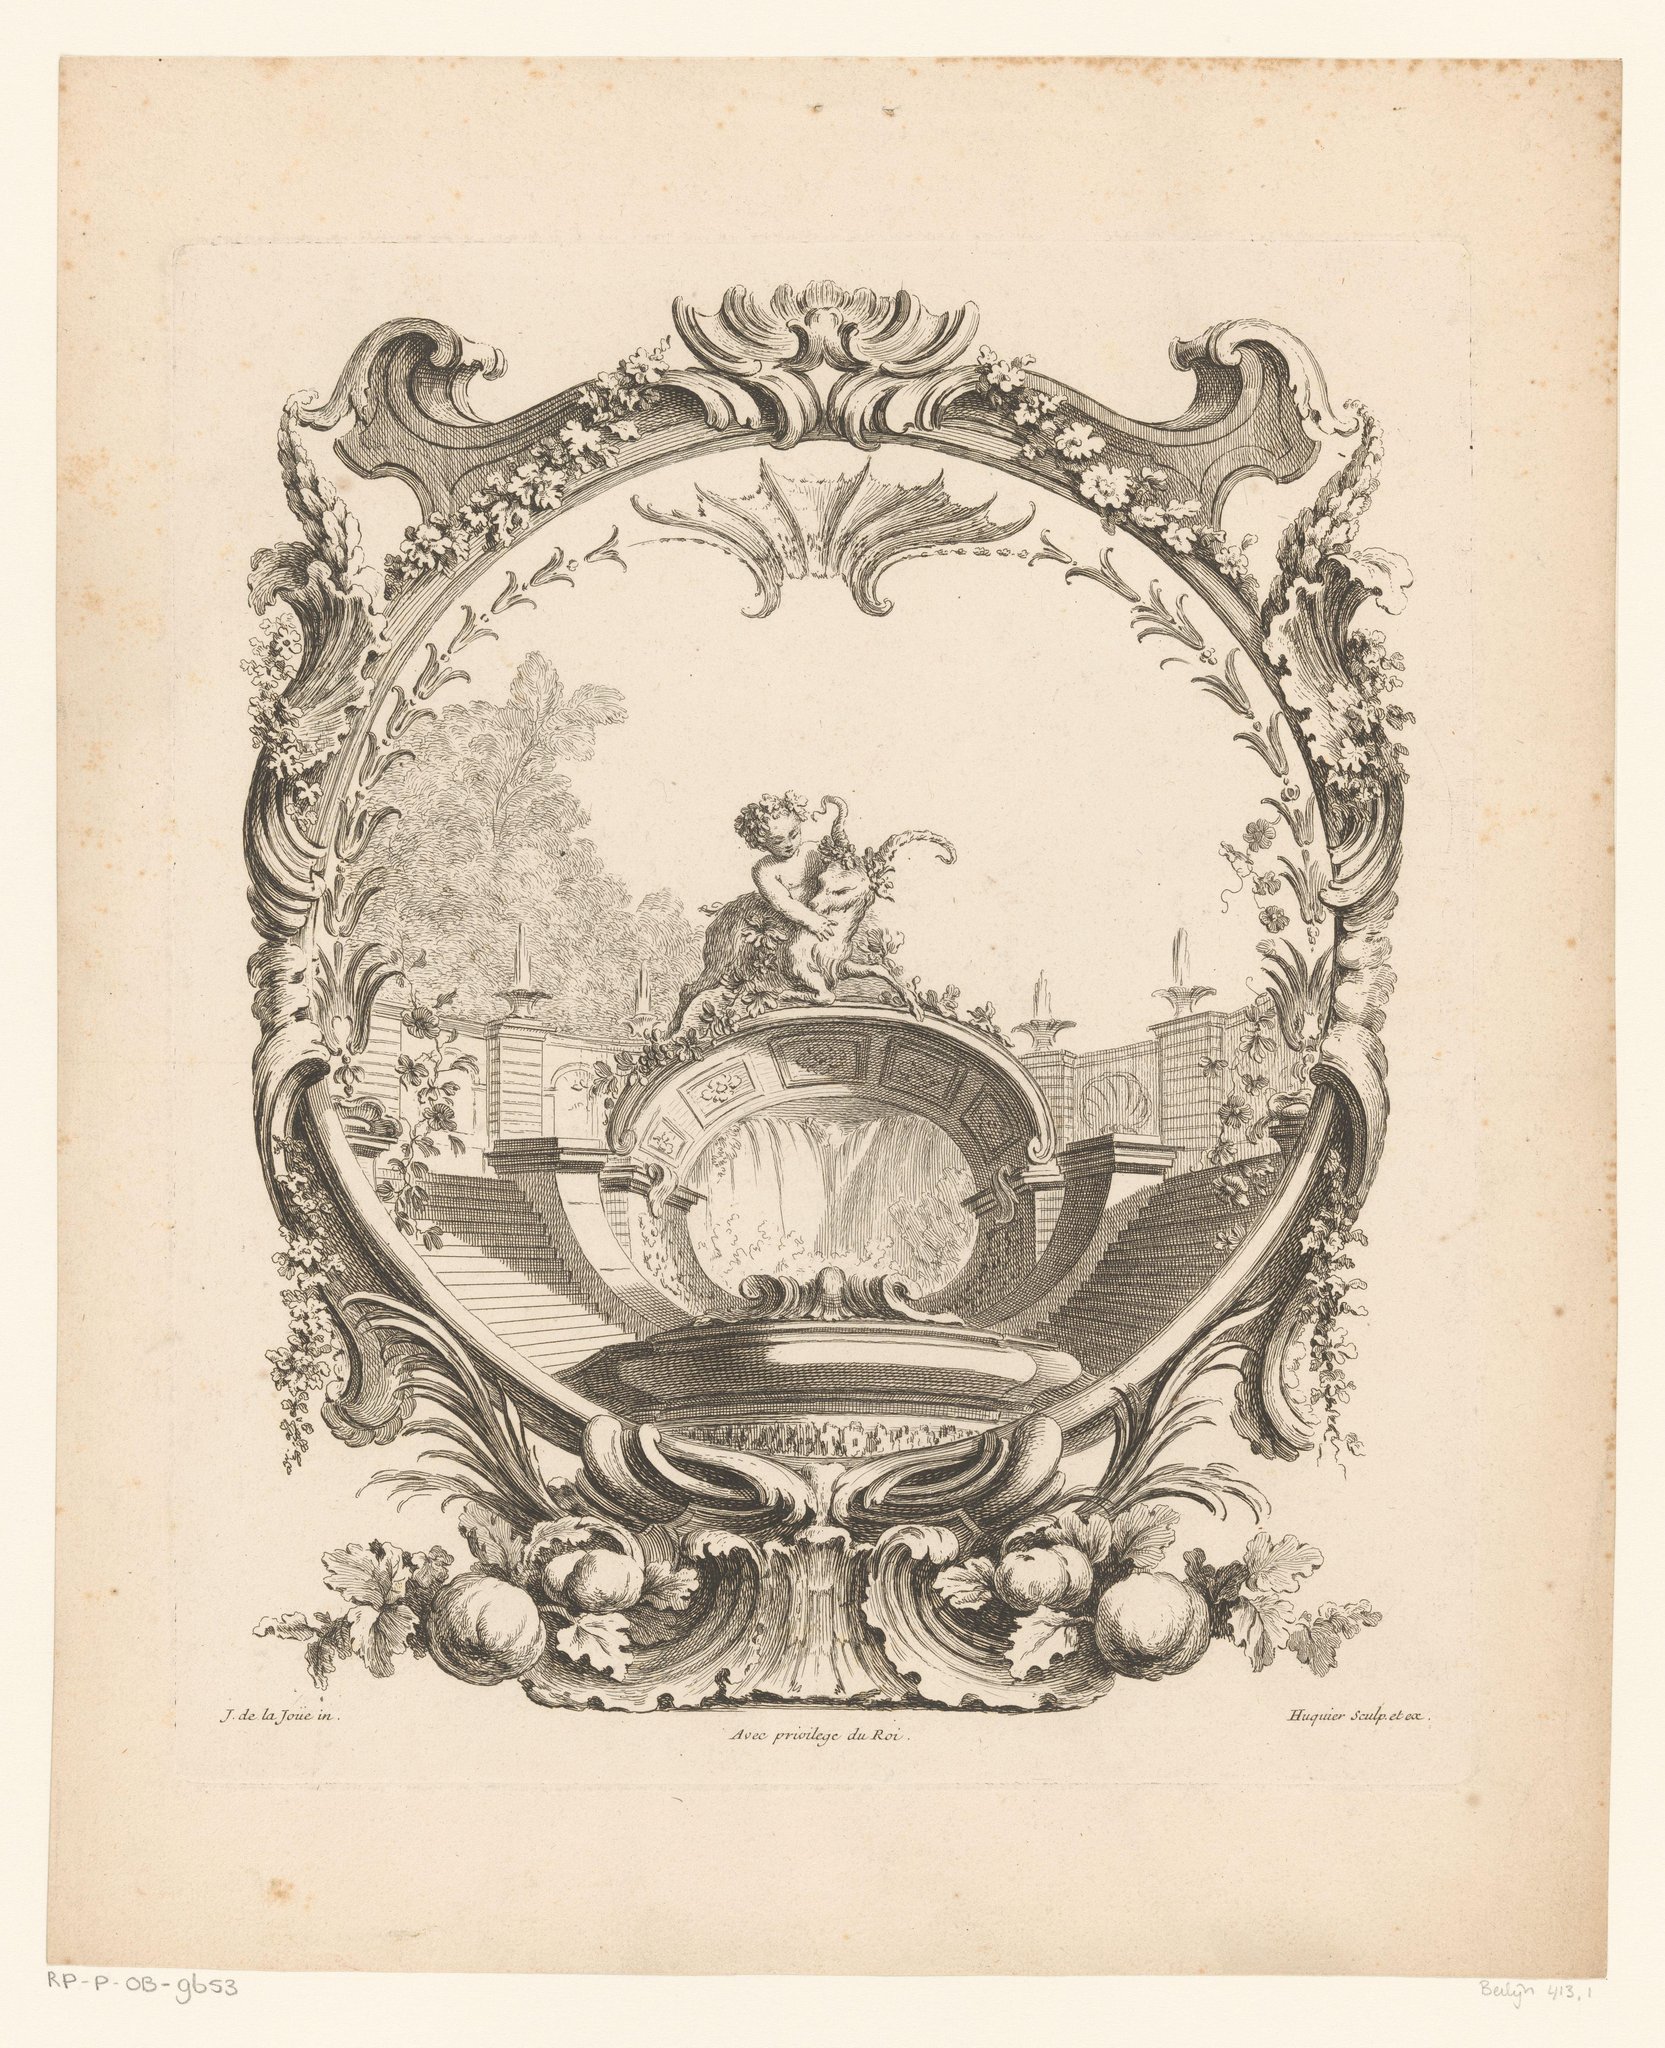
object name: print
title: Premier Livre De divers Morceaux D'Architecture Paysages Et Perspectives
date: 1731-1761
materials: paper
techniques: etching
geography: paris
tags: ram, garden, cupids: 'amores', 'amoretti', 'putti'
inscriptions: collector's mark: Lugt 2228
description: Een putto met krans van wijnranken staat met een ram op een ronde doorkijk. Links en rechts van de doorkijk leiden trappen omhoog richting een muur met fonteinen in de achtergrond. Rondom de voorstelling een ronde omlijsting met vruchten.